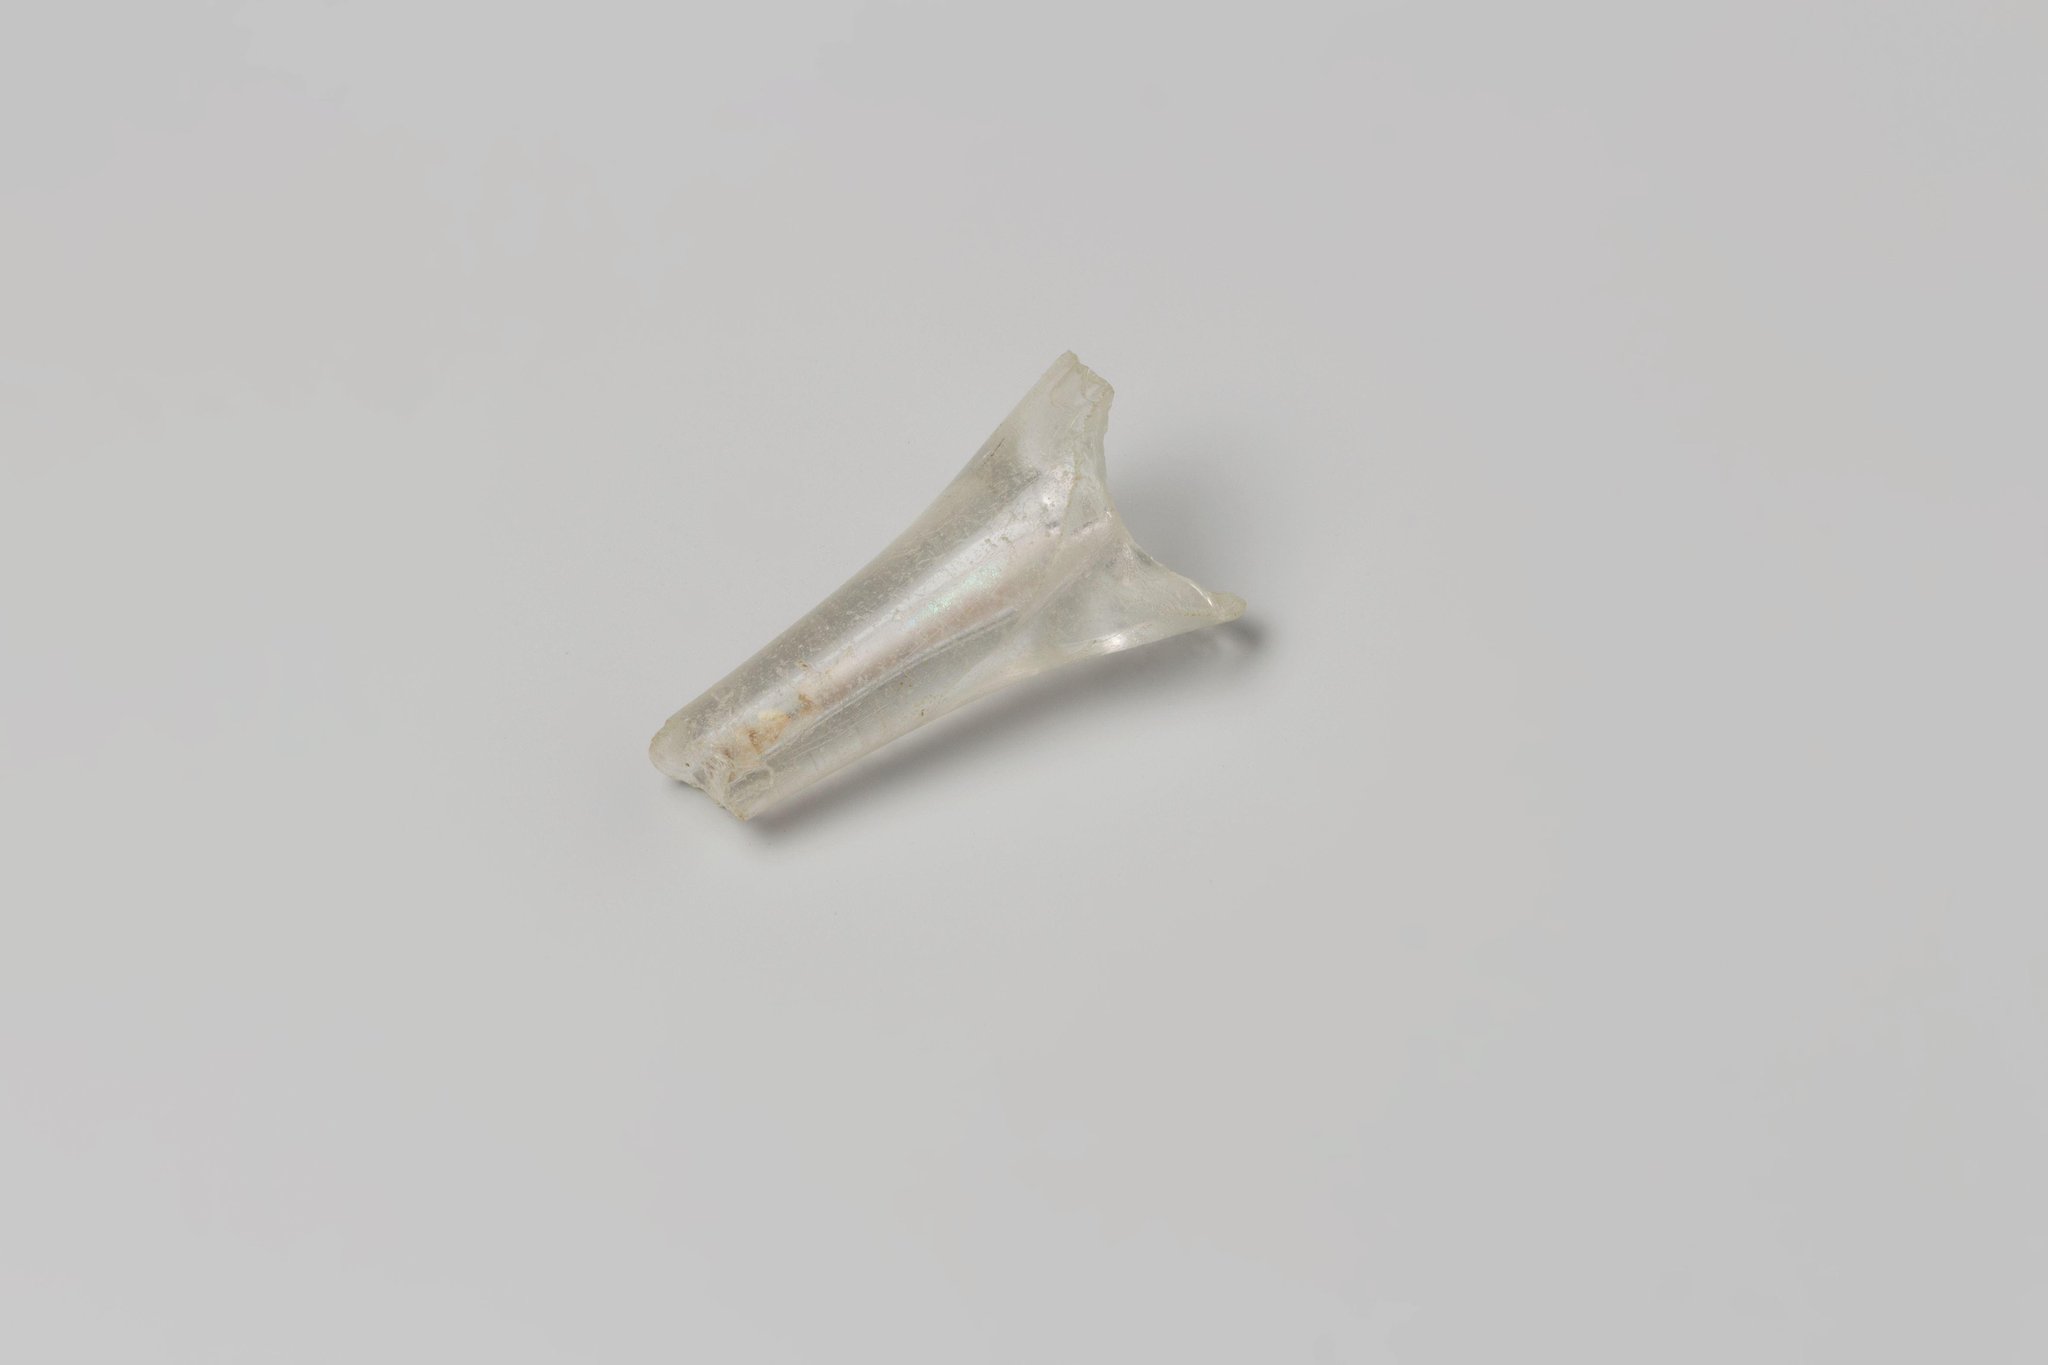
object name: helve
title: Rechte steel van glas uit het wrak van de Oost-Indiëvaarder Hollandia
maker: Anonymous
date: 1700-1743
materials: glass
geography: netherlands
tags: verenigde oostindische compagnie, hollandia (schip), annet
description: Glass, stem glass, stems, plain; fragm, id. NG 1980-27H798.